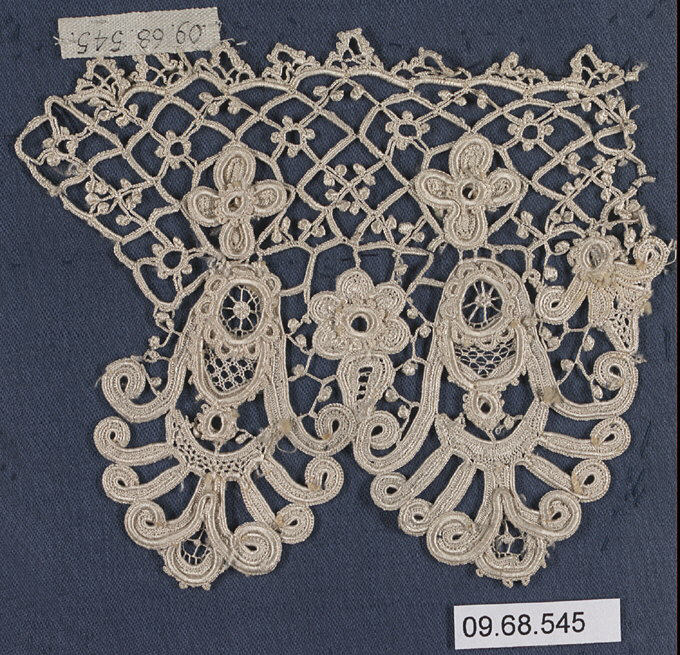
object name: specimen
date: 1801-1900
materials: silk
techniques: crochet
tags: flowers